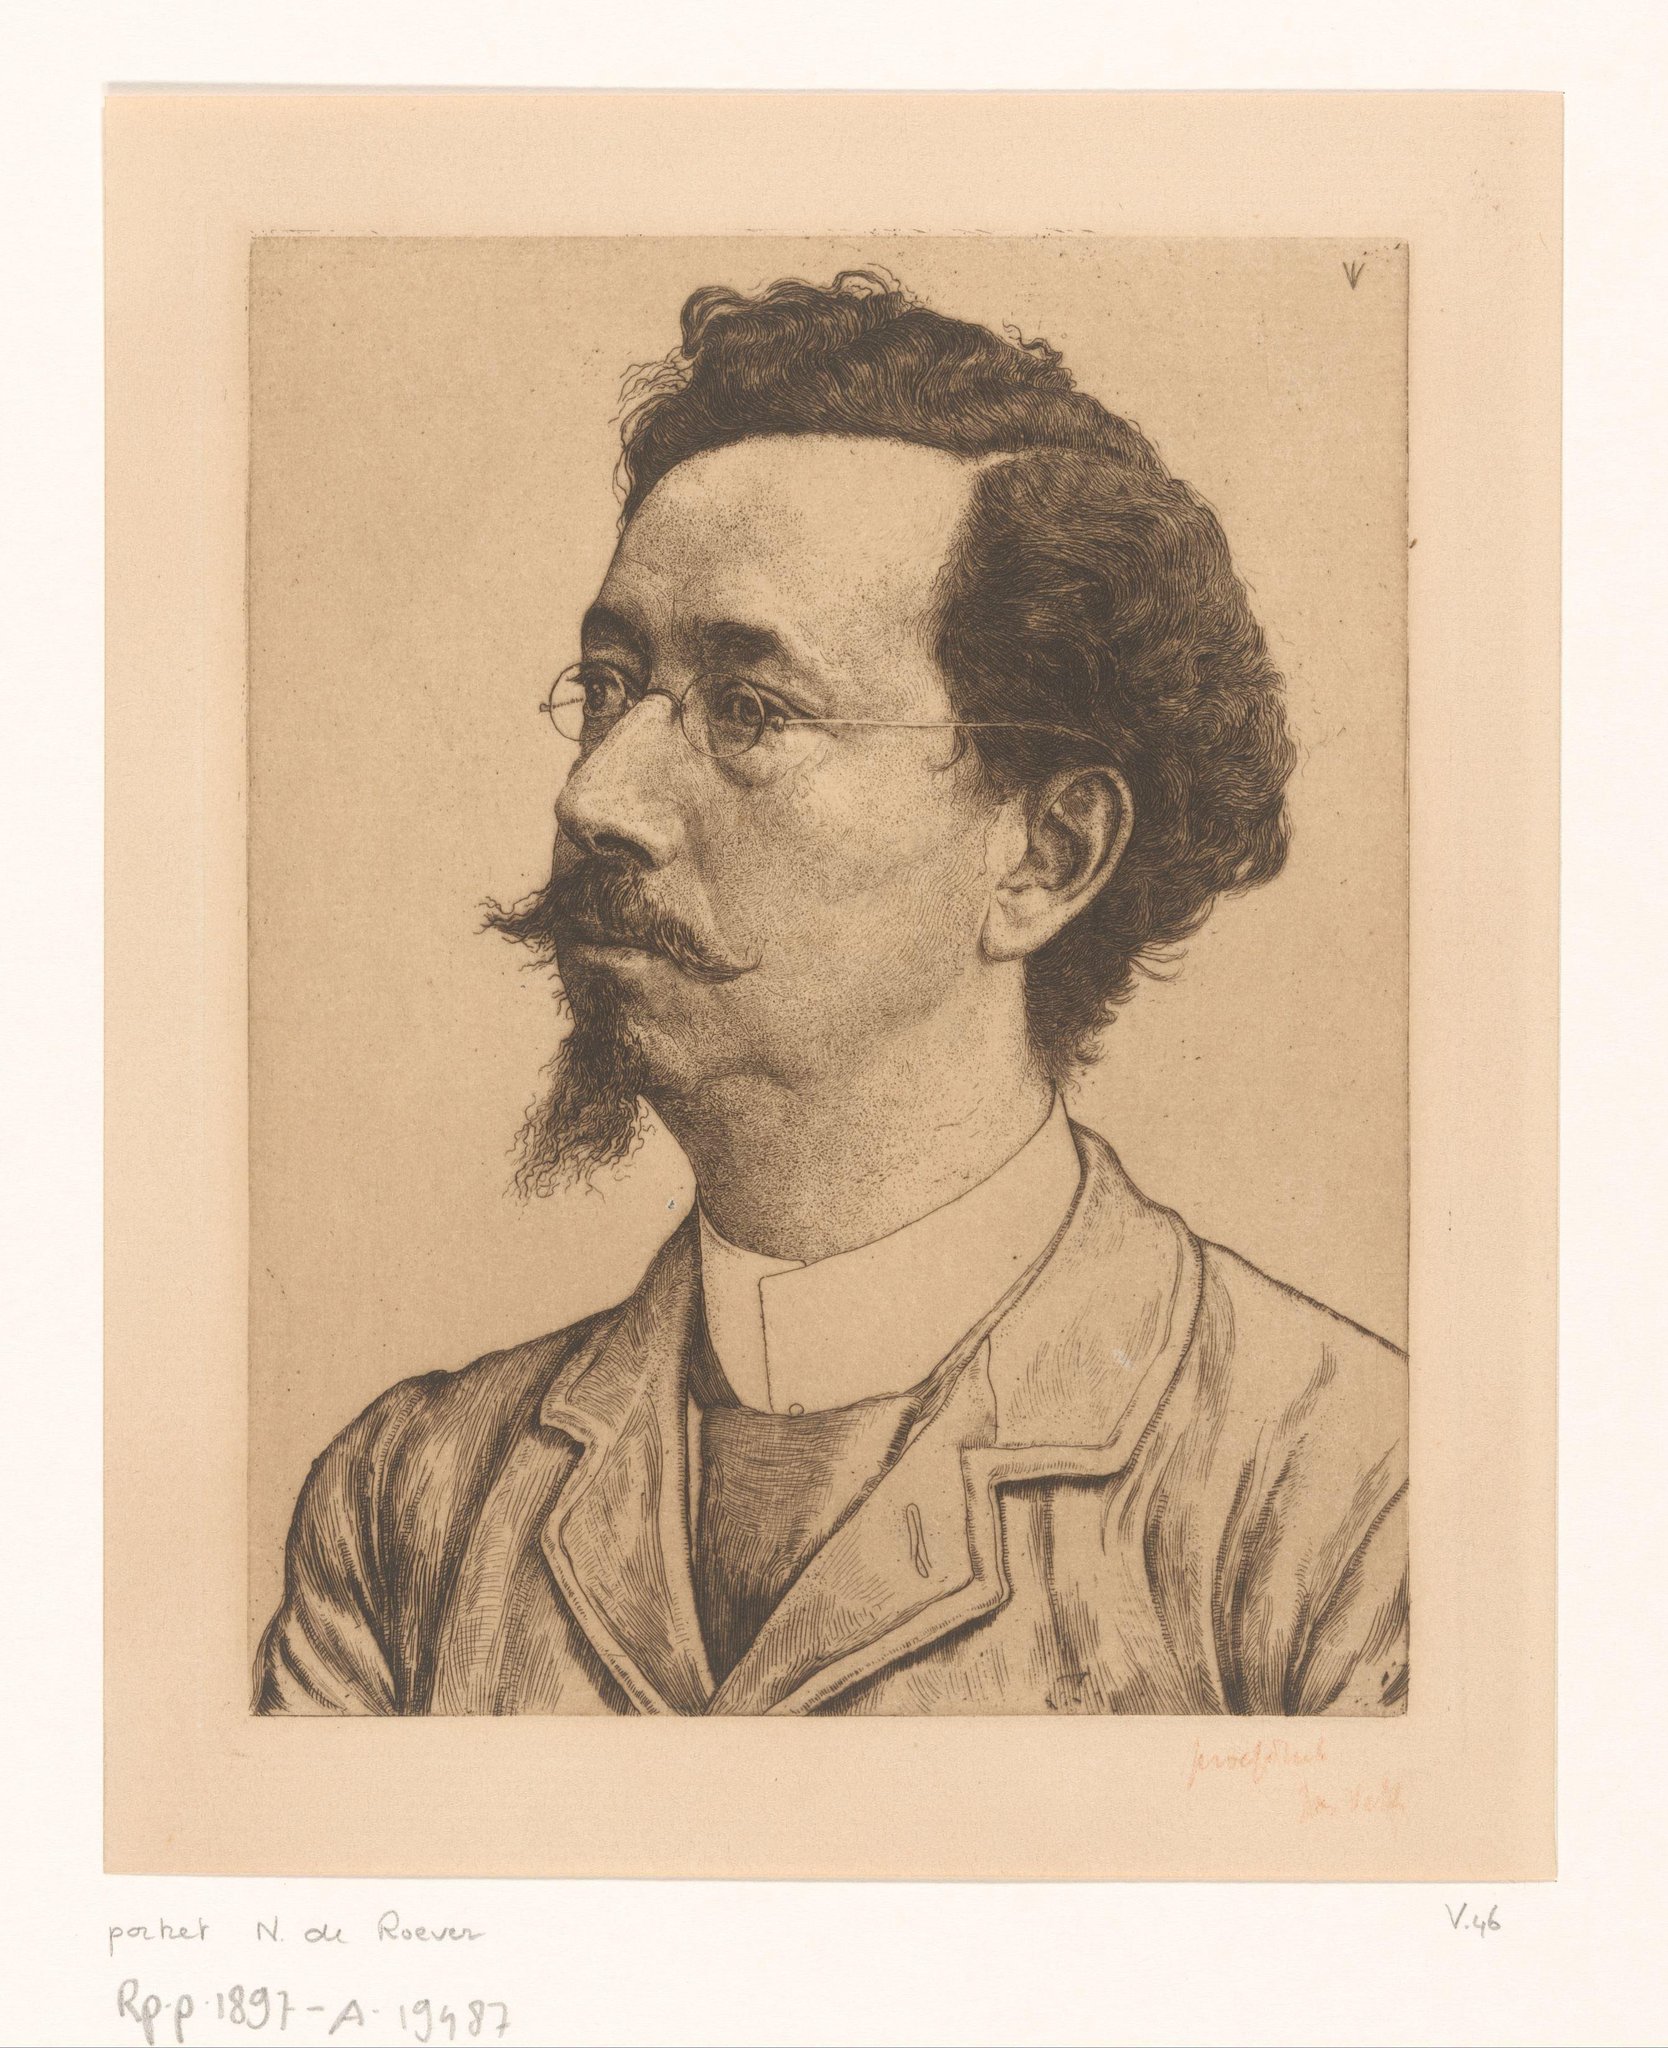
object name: print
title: Portret van Nicolaas de Roever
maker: jan veth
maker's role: designer, draughtsman, painter, print maker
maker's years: 1864-1925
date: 1893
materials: paper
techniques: drypoint, etching, intaglio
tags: amsterdam, historical persons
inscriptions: collector's mark: Lugt 2228